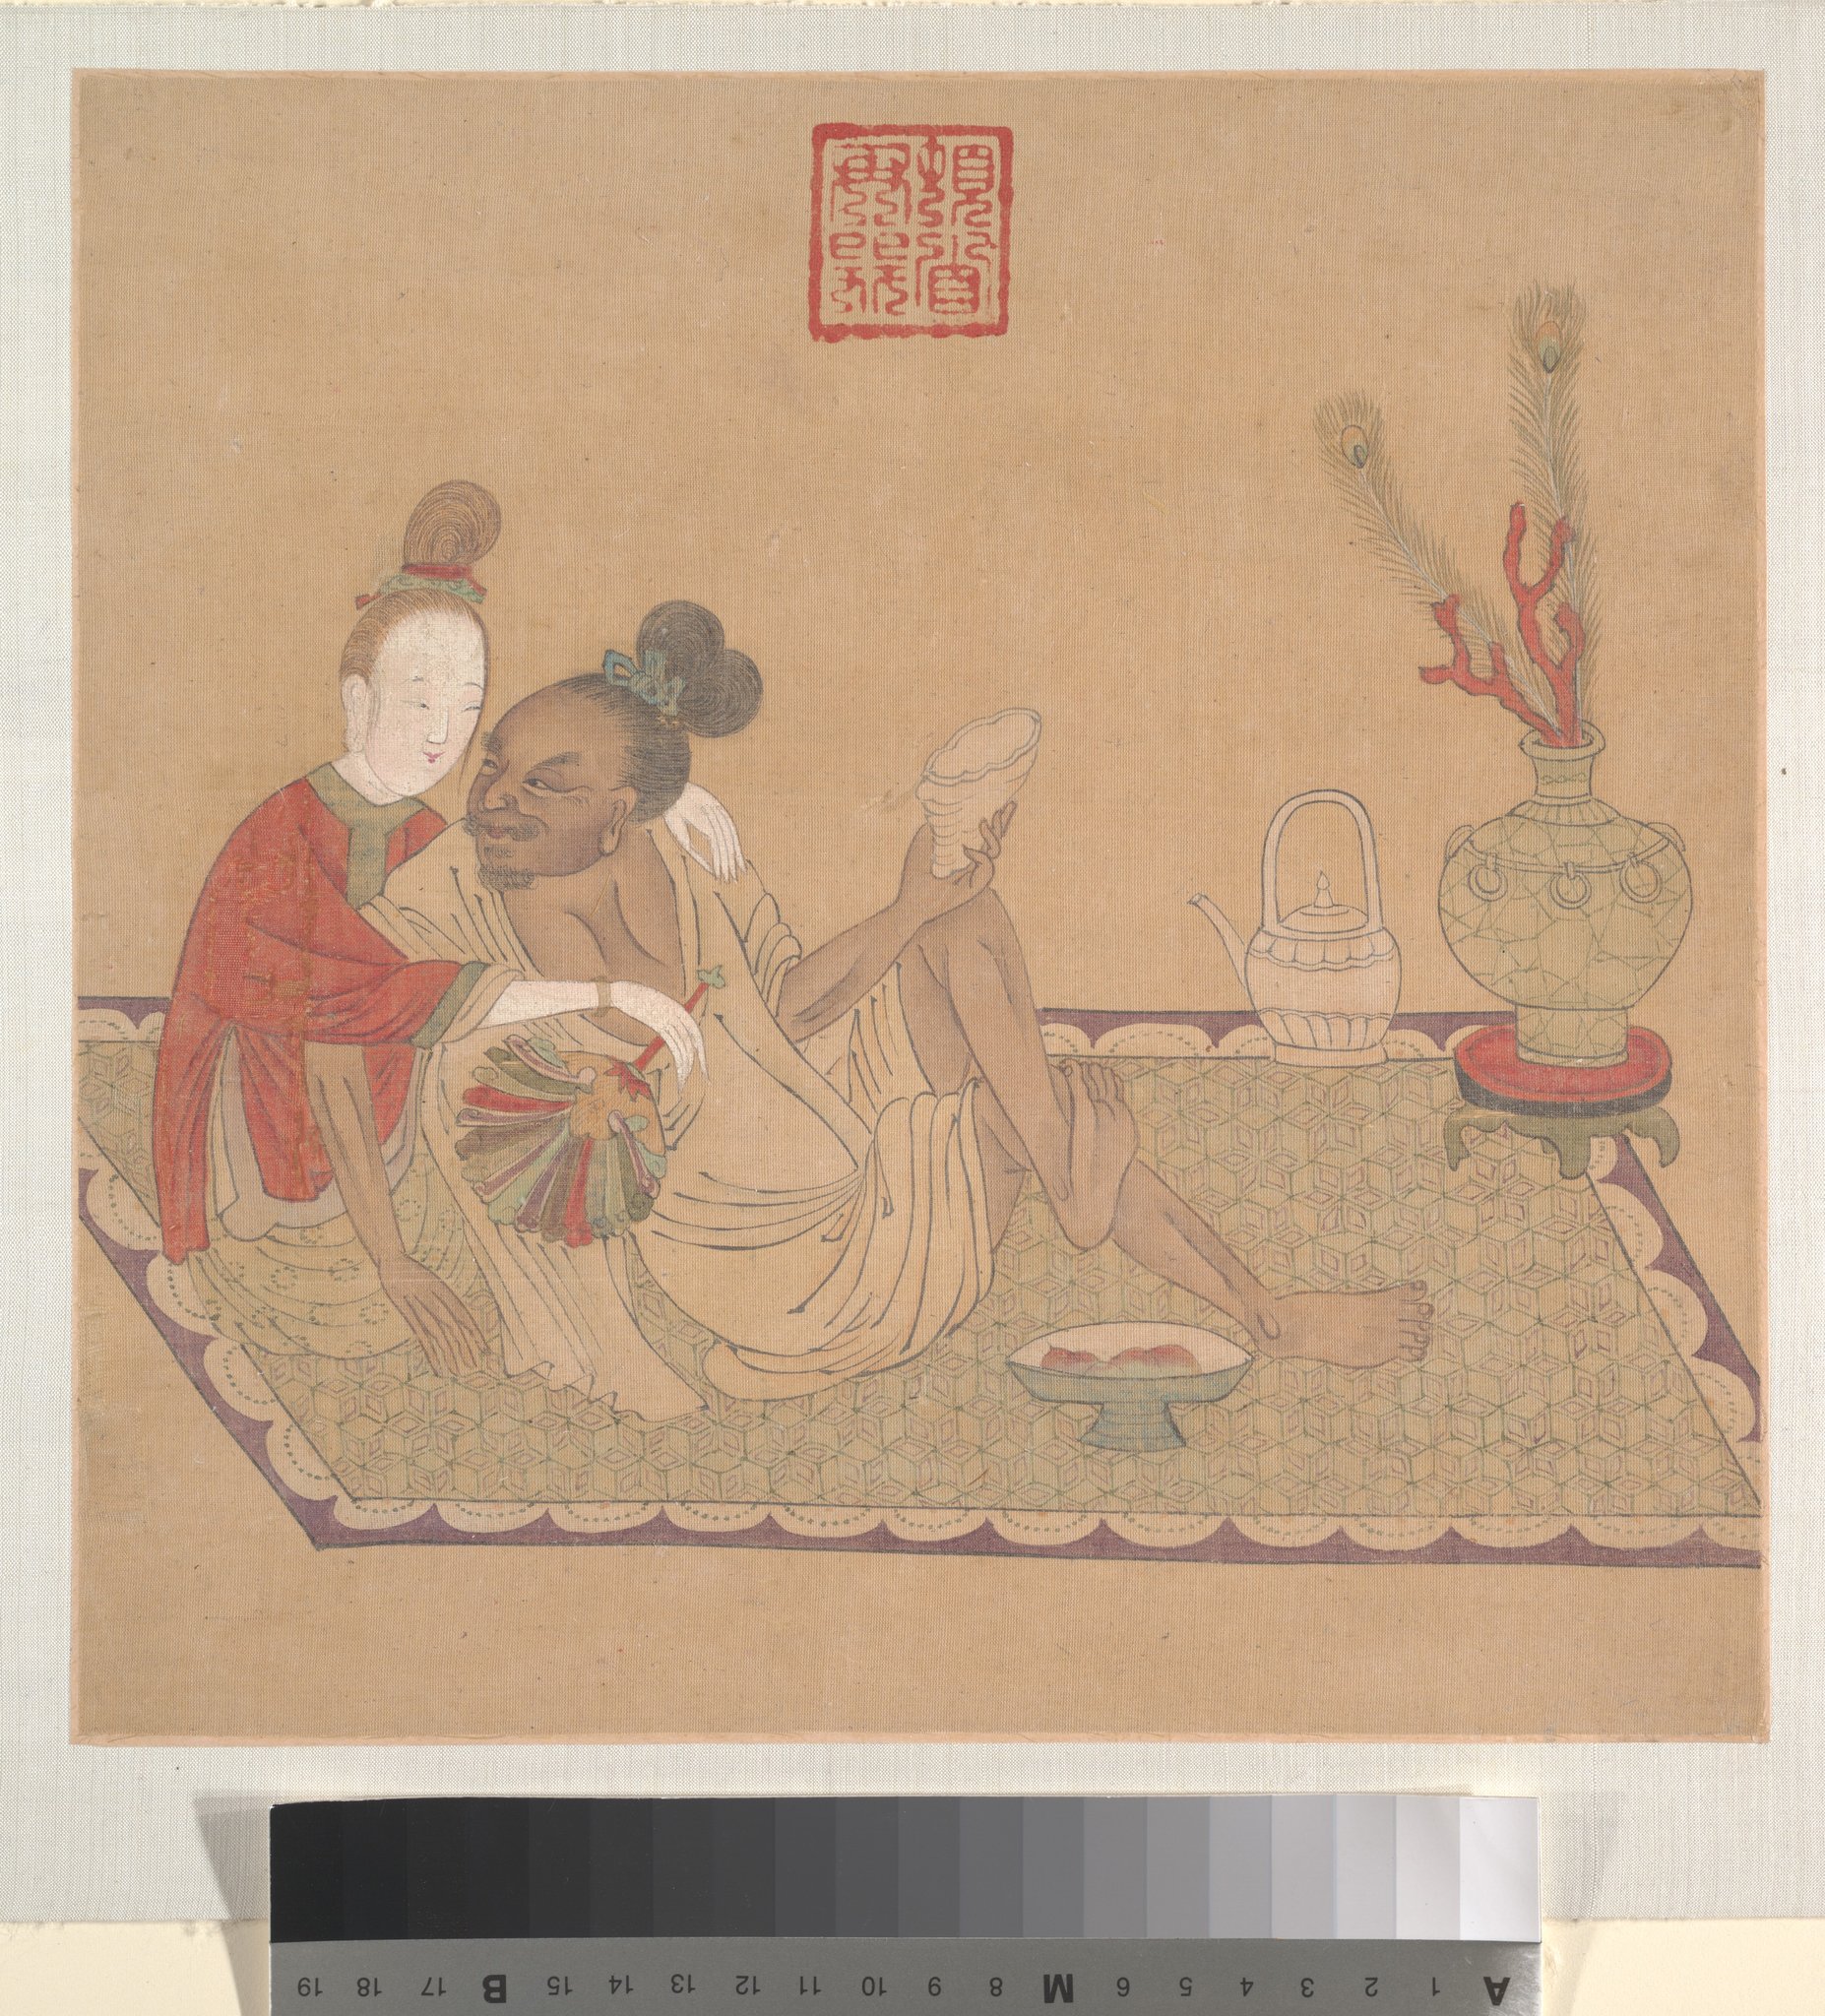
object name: album leaf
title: Tartar Officer with Blond Lady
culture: chinese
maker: unidentified artist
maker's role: artist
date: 1644-1911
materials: ink, silk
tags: fans,men,women